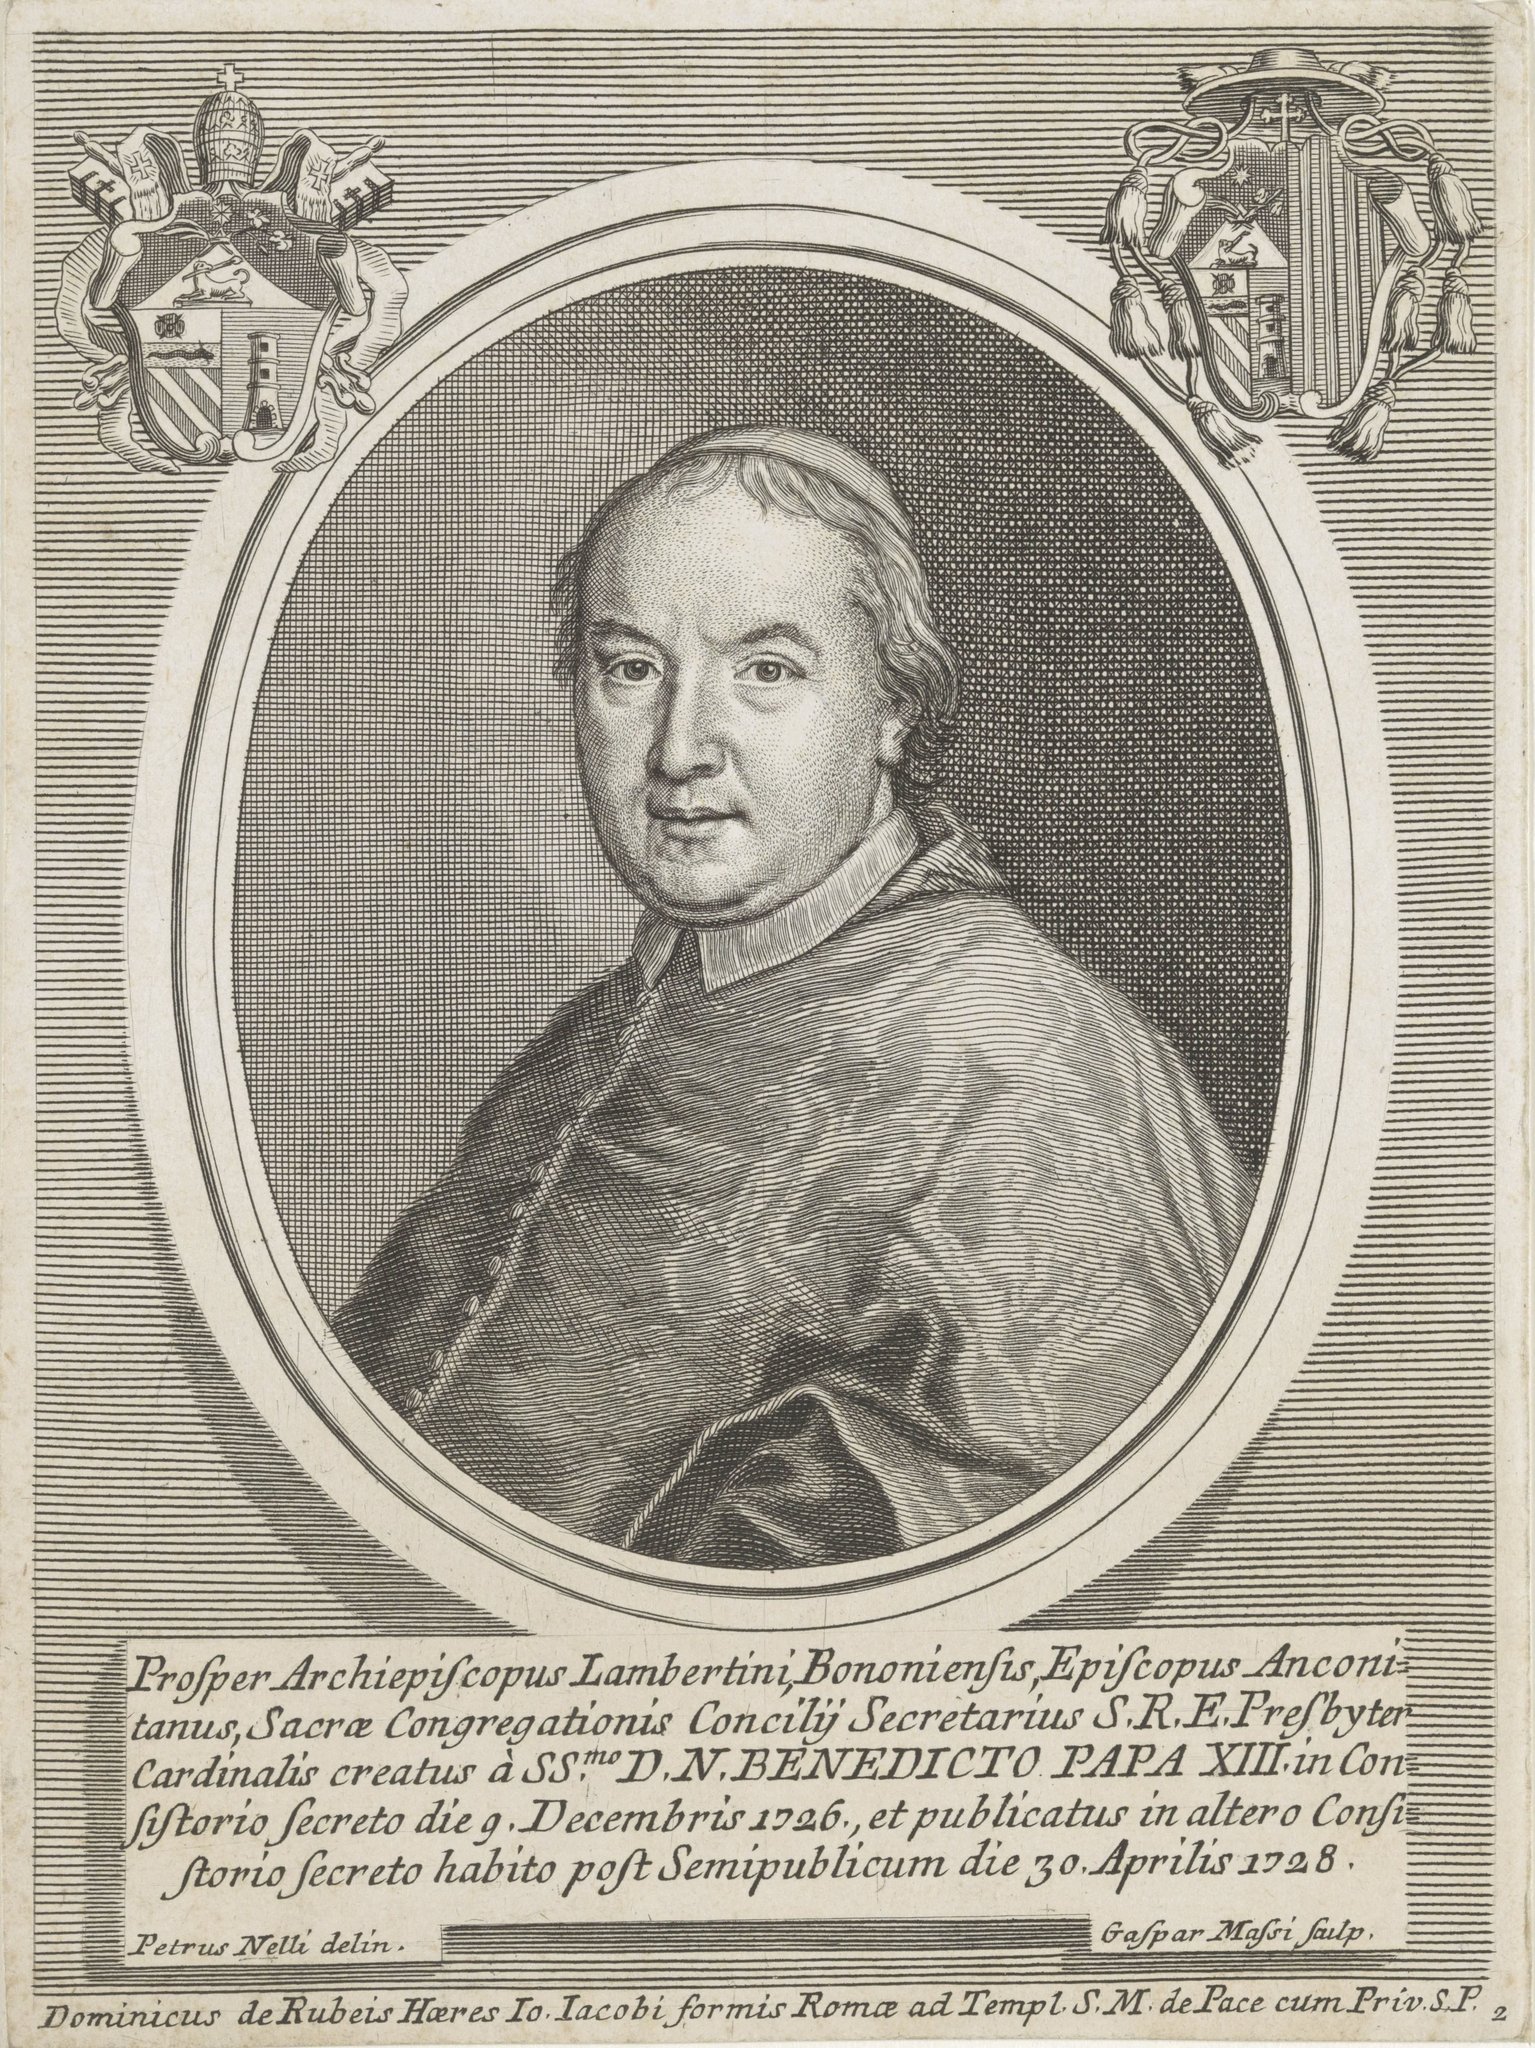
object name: print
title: Portret van kardinaal Prospero Lorenzo Lambertini, de latere paus Benedictus XIV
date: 1728-1731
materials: paper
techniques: engraving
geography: vatican city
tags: rome, benedictus xiv, cardinal, historical persons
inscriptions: collector's mark: Lugt 2228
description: Prent uit een reeks van onbekende omvang met portretten van kardinalen. De prenten werden vanaf 1657 vervaardigd in opdracht van uitgever Giovanni Giacomo de’ Rossi, waarna de productie werd voortgezet onder leiding van zijn opvolgers Domenico de’ Rossi en Lorenzo Filippo de’ Rossi, en tenslotte onder leiding van de Calcographia R.C.A.